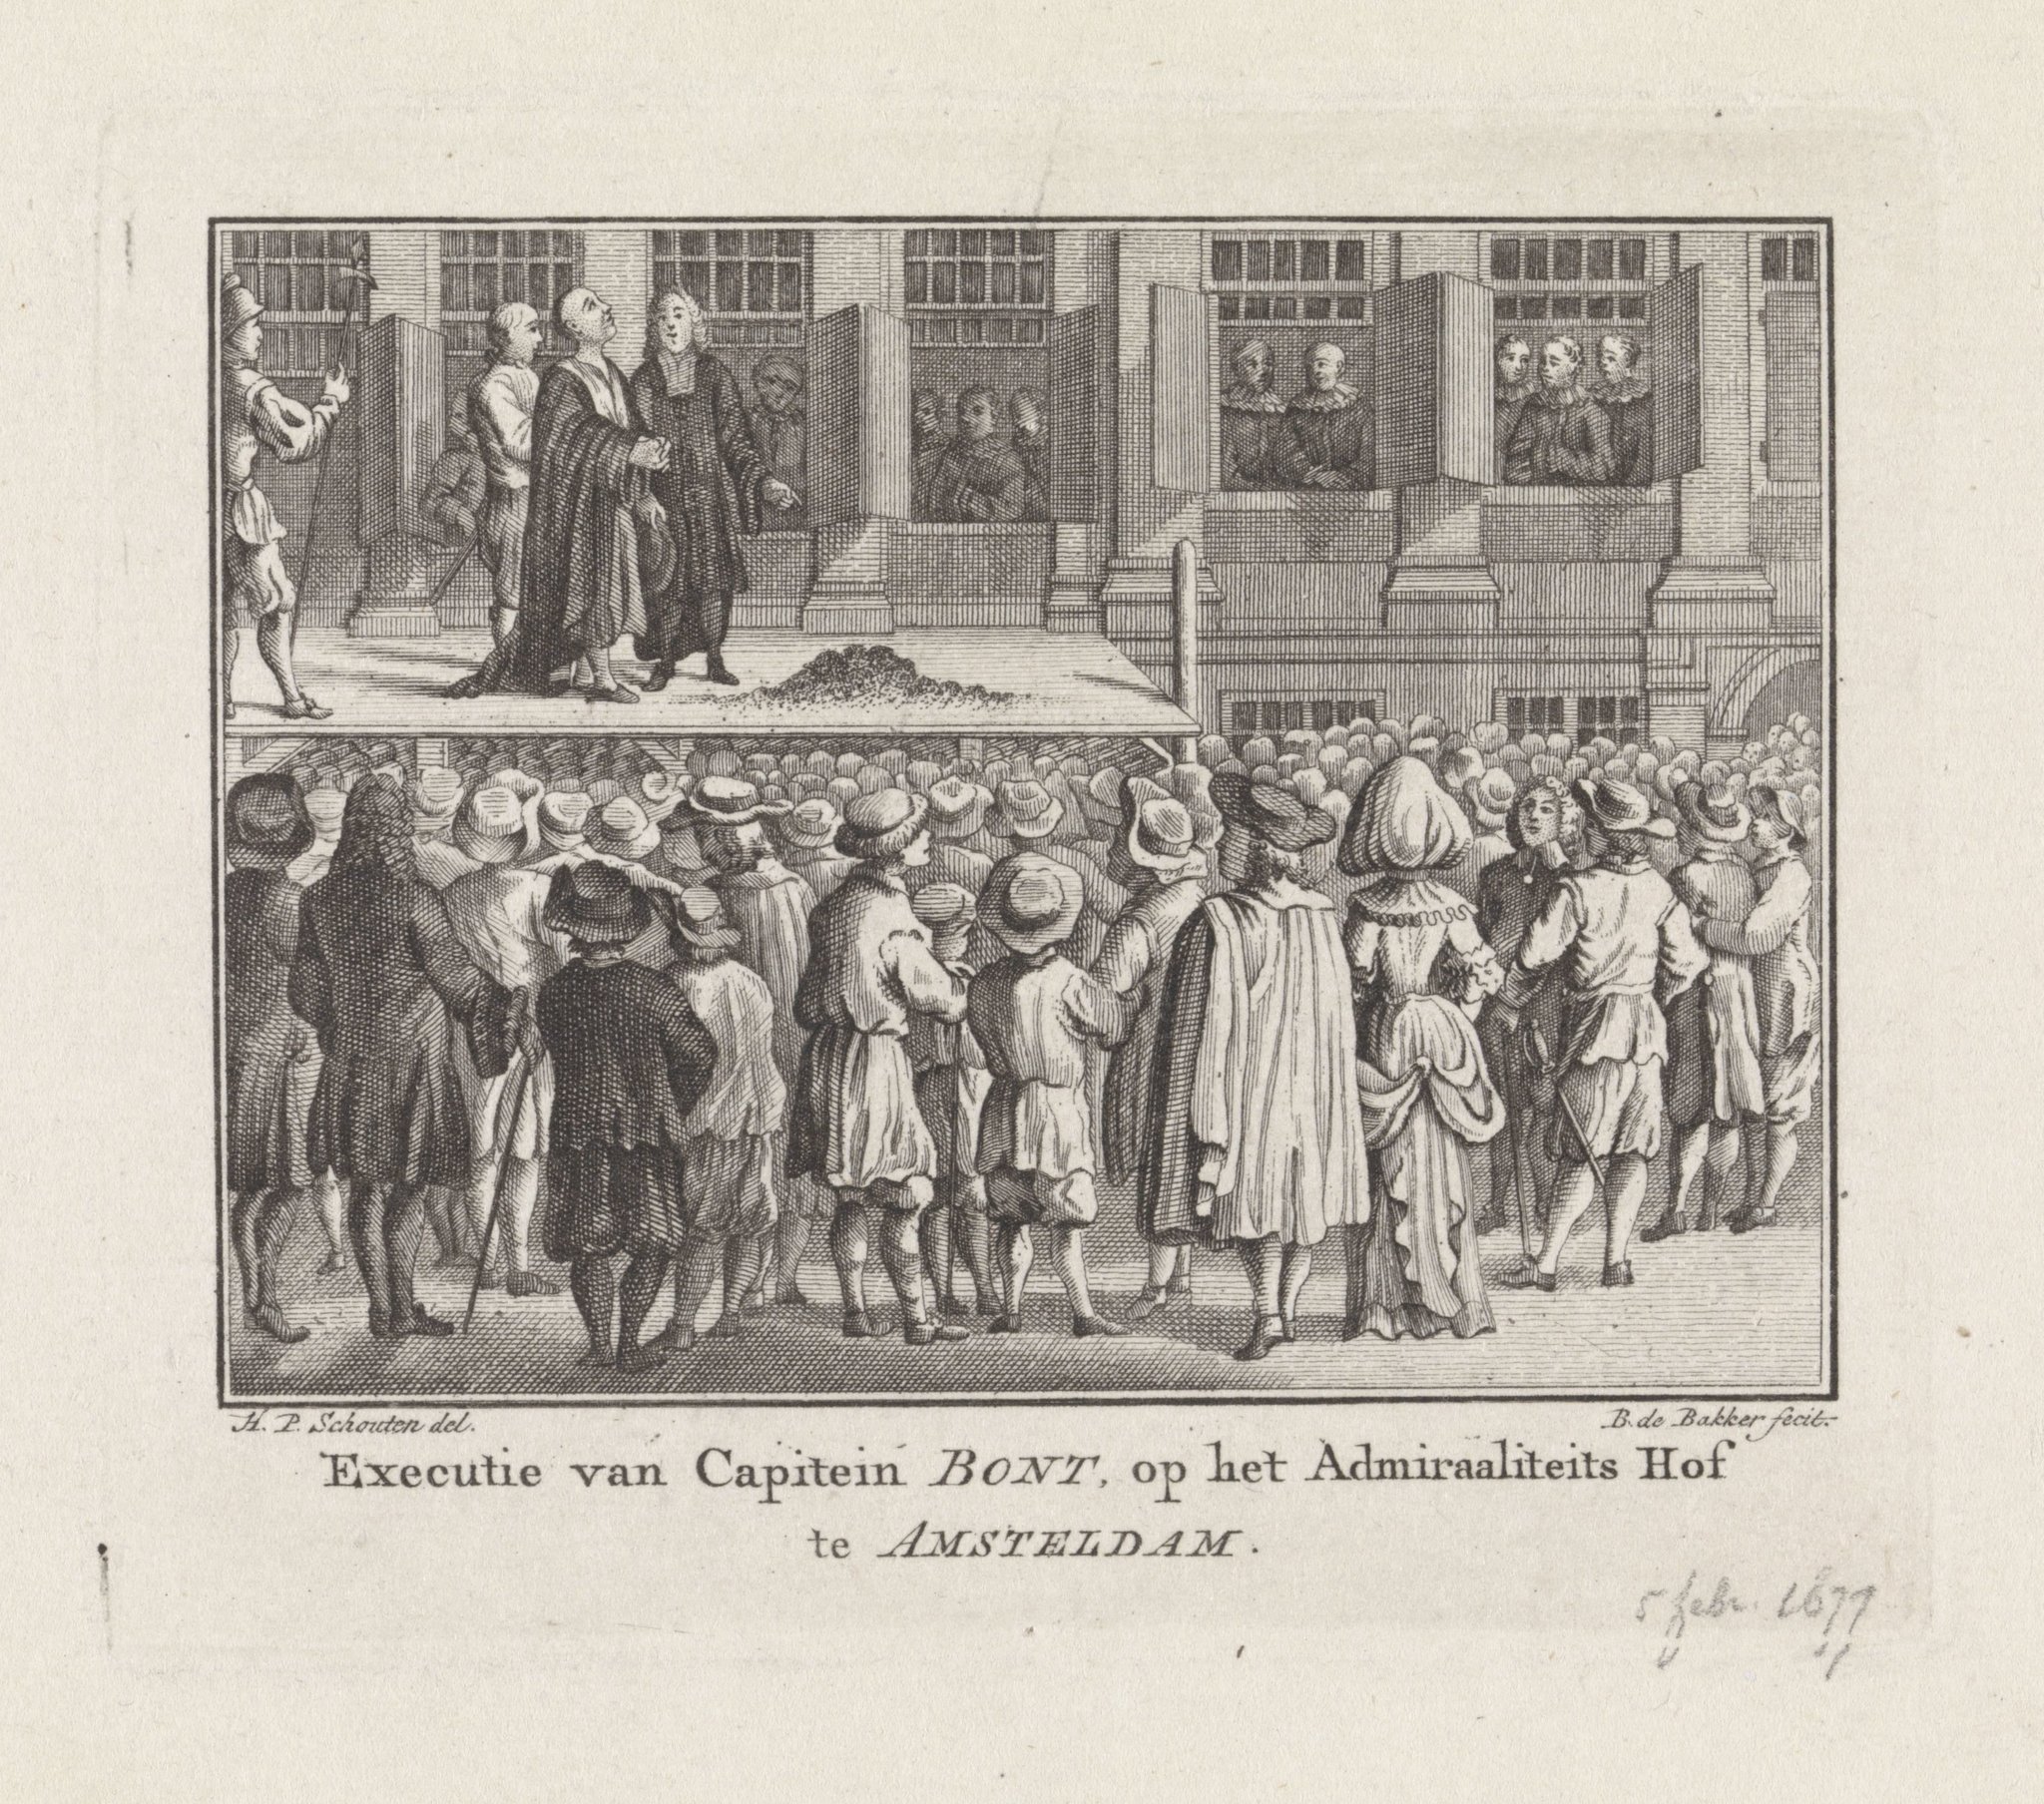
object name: print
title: Executie van kapitein Bont op het Admiraliteits Hof te Amsterdam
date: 1782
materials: paper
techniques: engraving, etching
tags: violent death, being killed; being mishandled and maltreated; seeking death (+ execution (by judicial verdict))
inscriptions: collector's mark: Lugt 2228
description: Executie van kapitein Bont op het Admiraliteits Hof te Amsterdam op 5 januari 1577 wegens het zonder toestemming vertrekken van de vloot van Binckes in West-Indië.